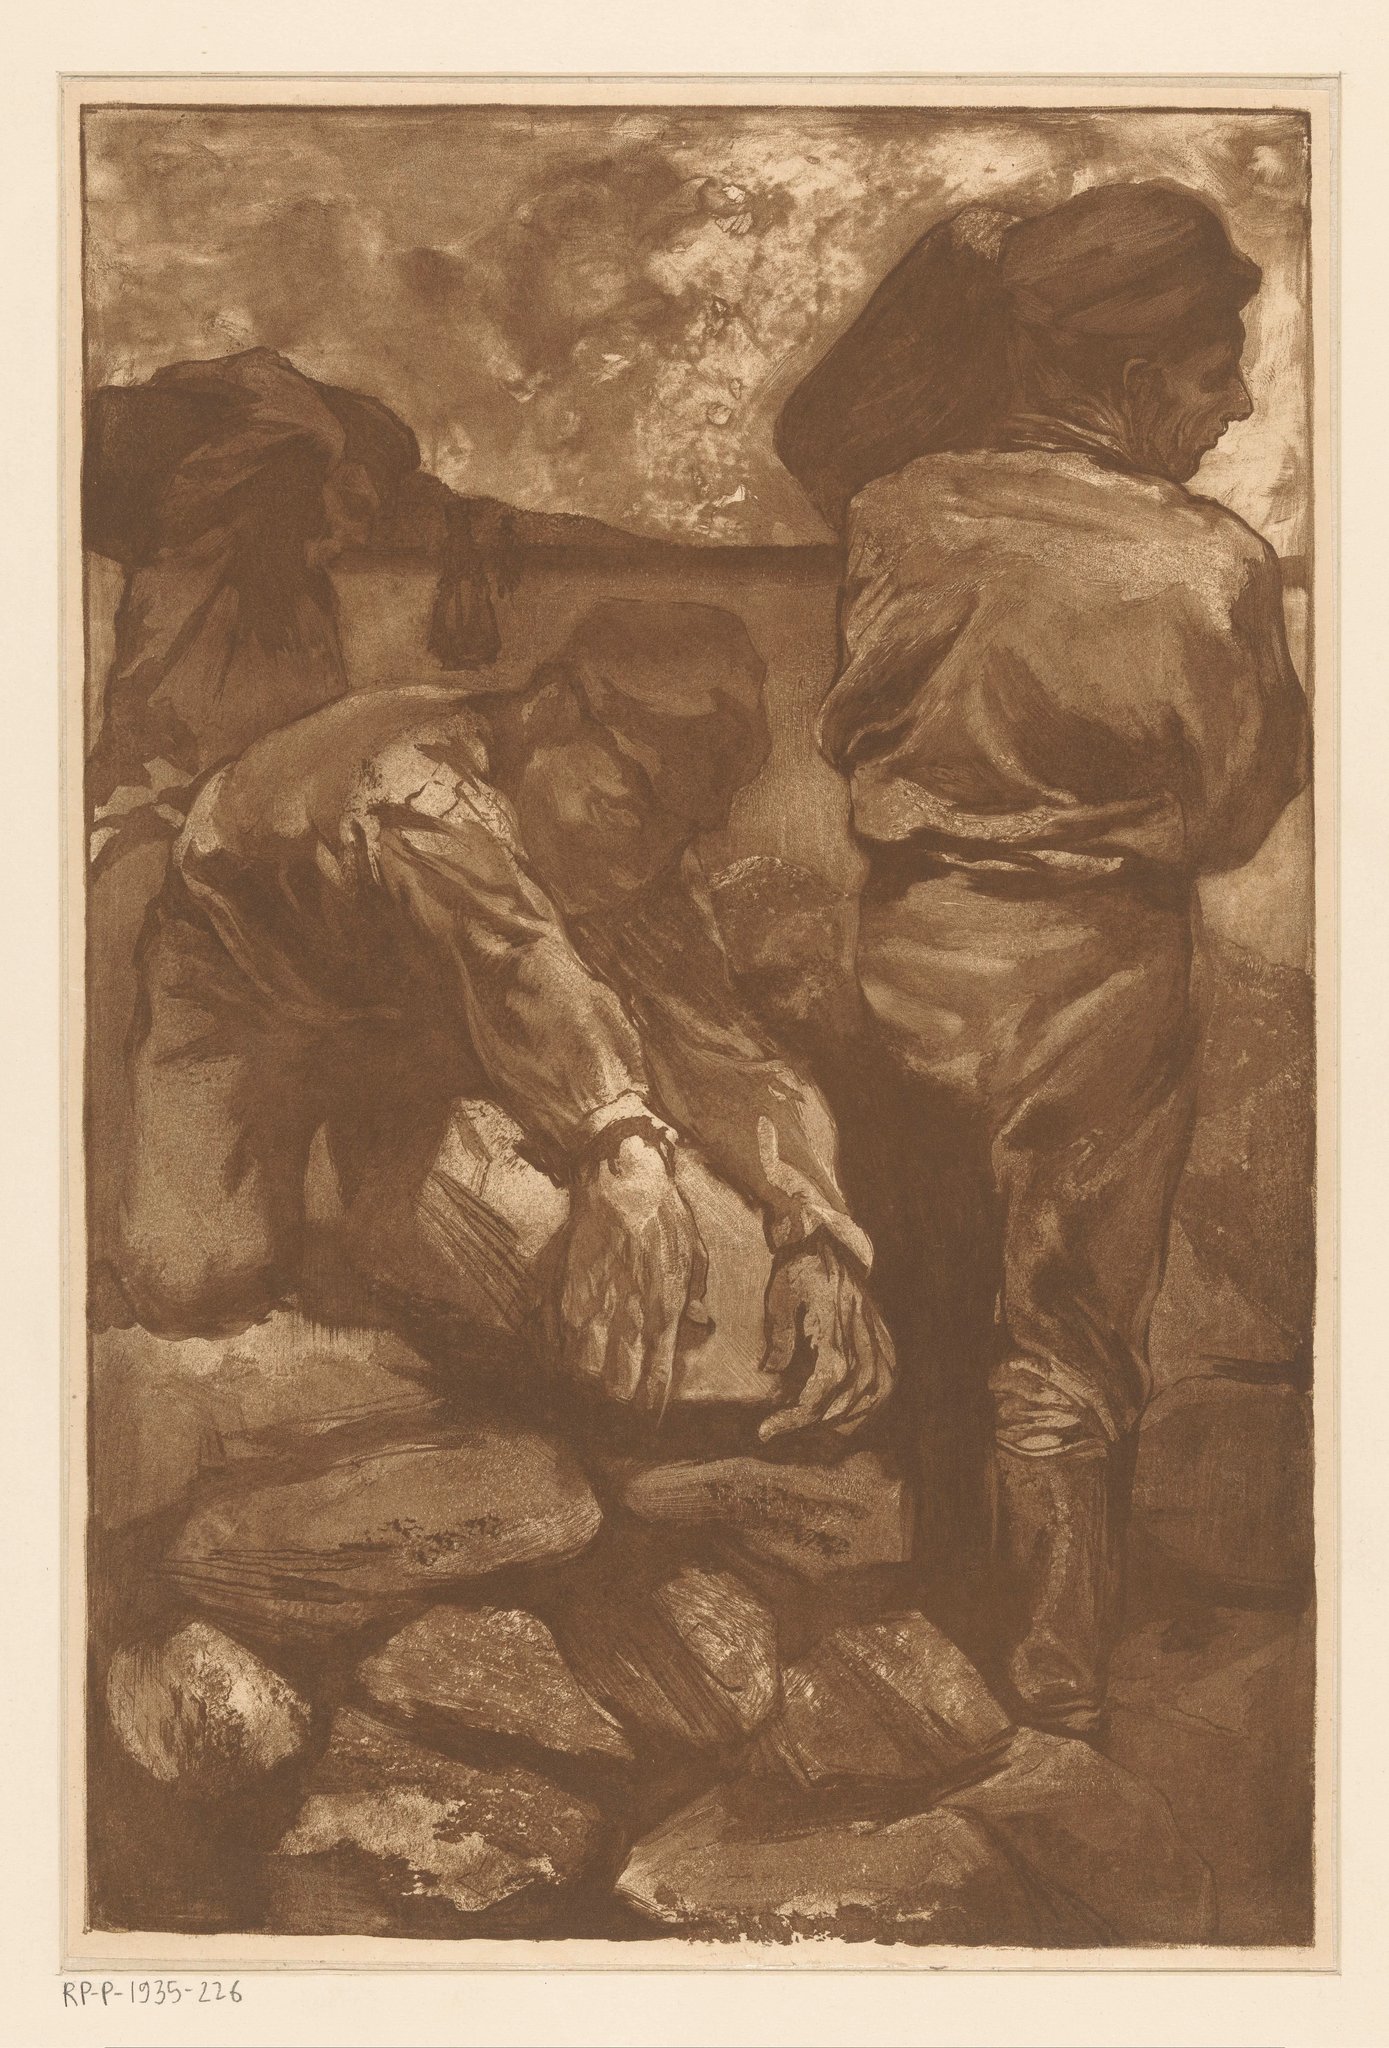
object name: print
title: Stenen sjouwende arbeiders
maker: johannes josephus aarts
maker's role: draughtsman, print maker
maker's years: 1871-1934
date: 1881-1934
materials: paper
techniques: lithograph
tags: working class, labourers, boulder, stone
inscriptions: collector's mark: Lugt 2228, collector's mark: Lugt 2760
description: Twee mannen in werkkleding en met pet sjouwen stenen. De man links tilt bukkend een steen op, terwijl de man rechts een steen op zijn schouder draagt. Op de achtergrond water.